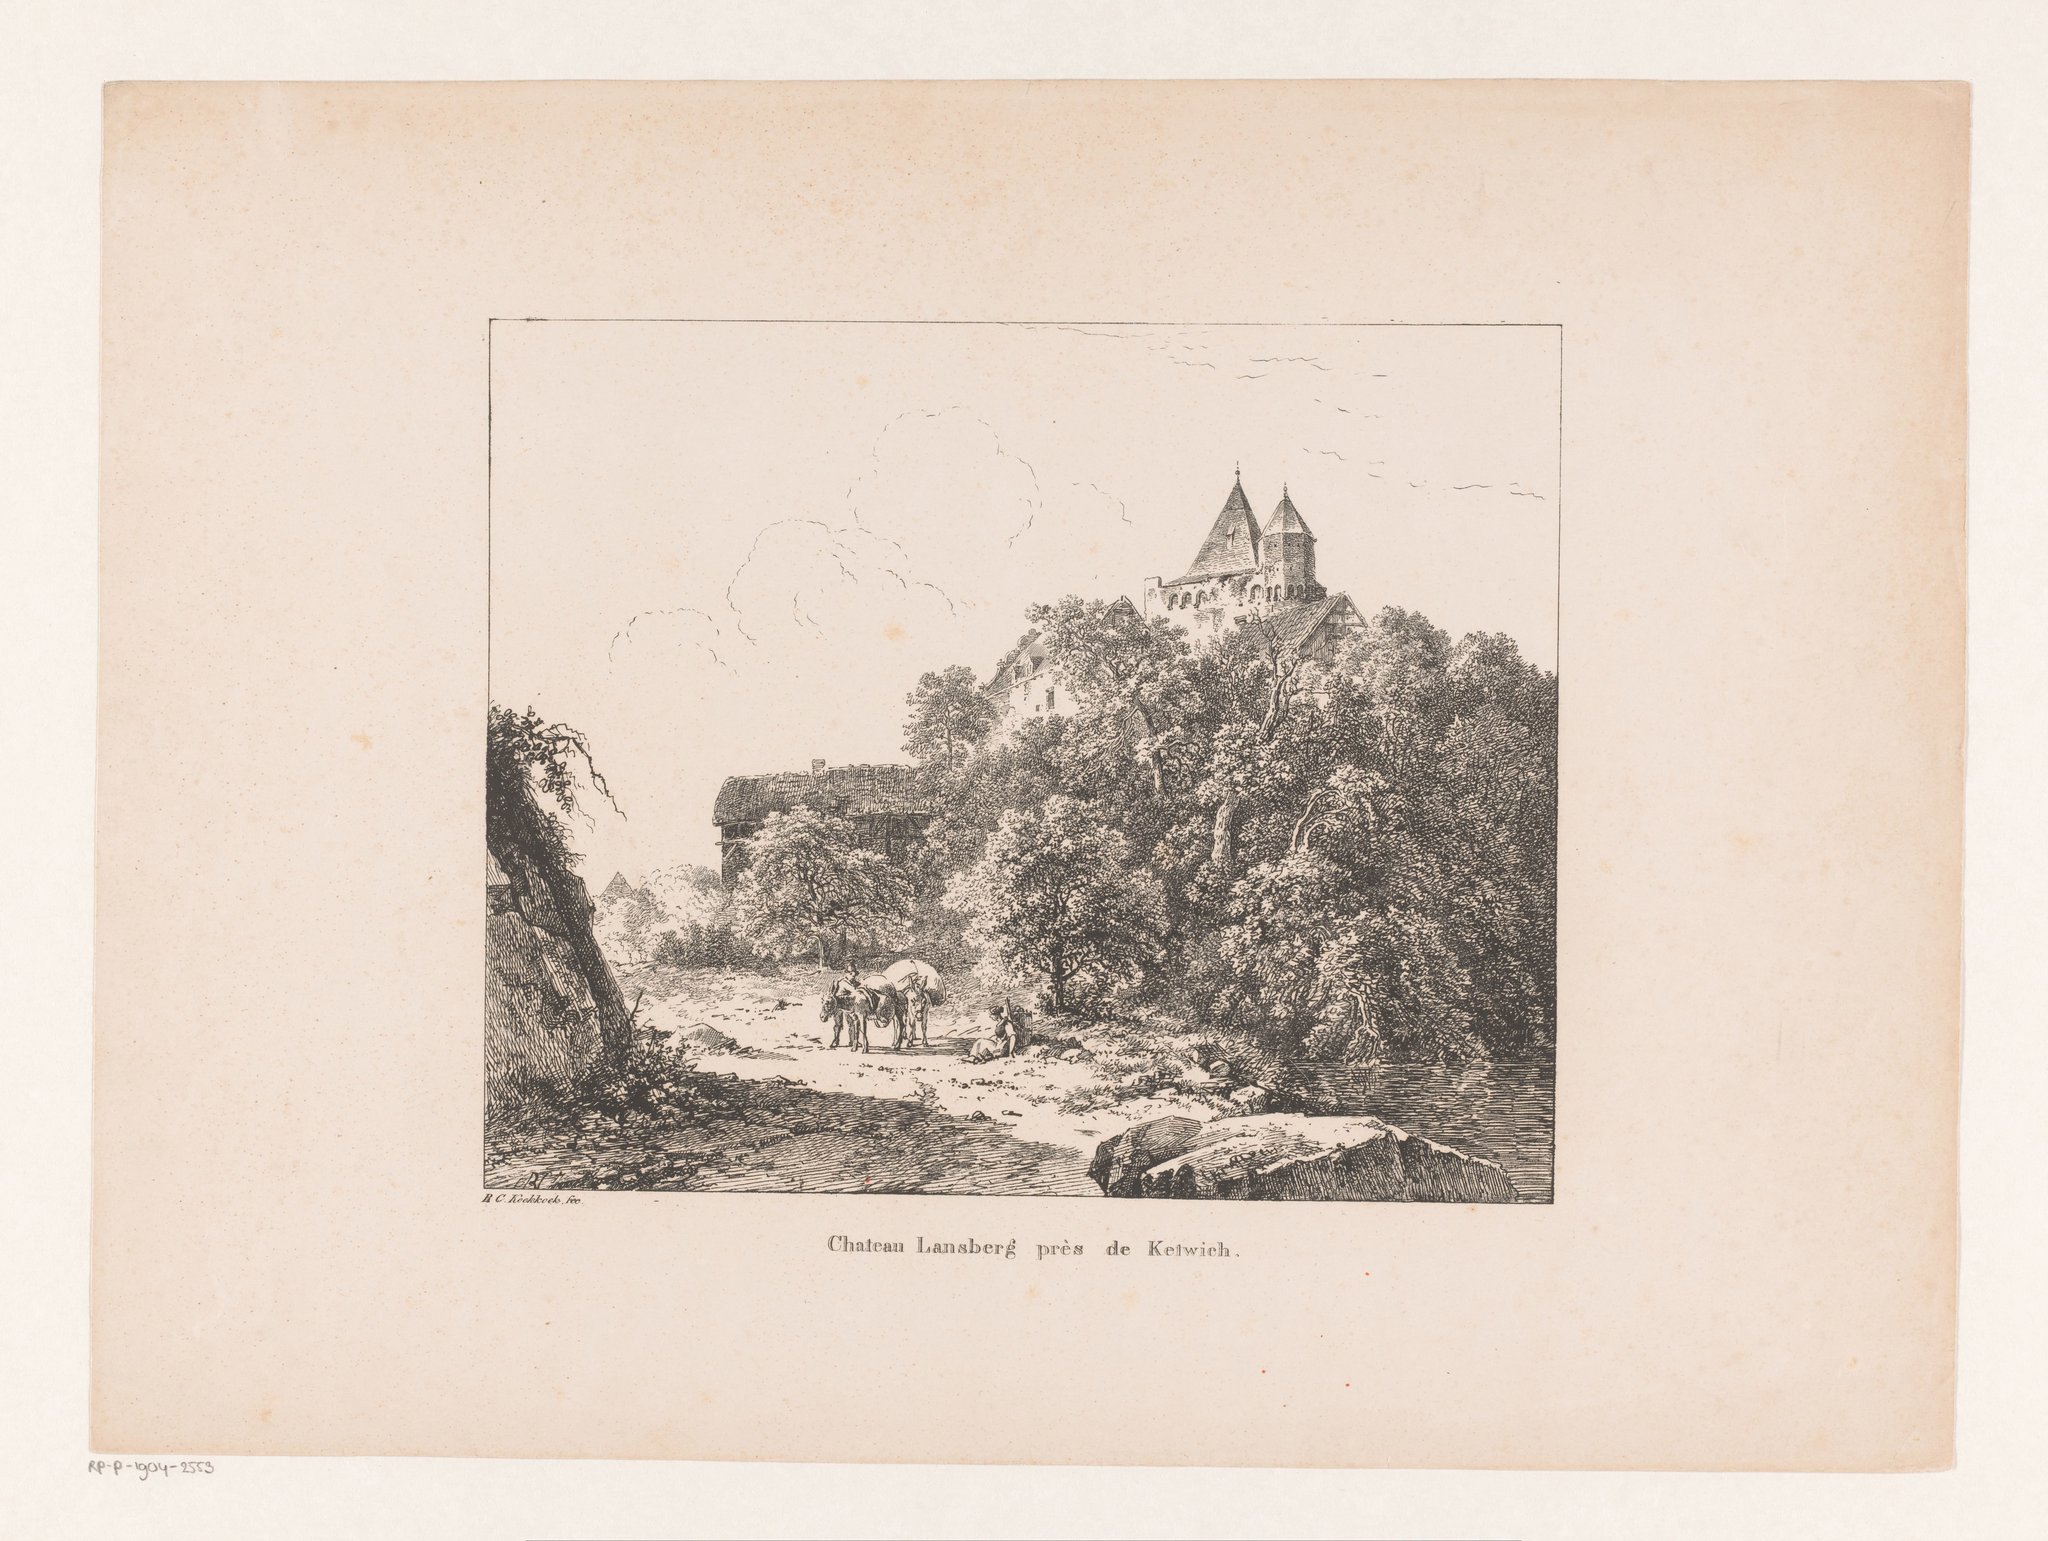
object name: print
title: Kasteel Lansberg bij Kettwig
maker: barend cornelis koekkoek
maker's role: draughtsman, painter, print maker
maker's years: 1803-1862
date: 1820-1833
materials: paper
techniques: lithograph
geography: amsterdam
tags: castle, landscape with tower or castle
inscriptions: collector's mark: Lugt 2228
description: Het kasteel is nog net zichtbaar tussen de toppen van de bomen. Op een landweg staat een figuur naast twee bepakte ezels. Een vrouw met een mand op haar rug zit onder een boom.